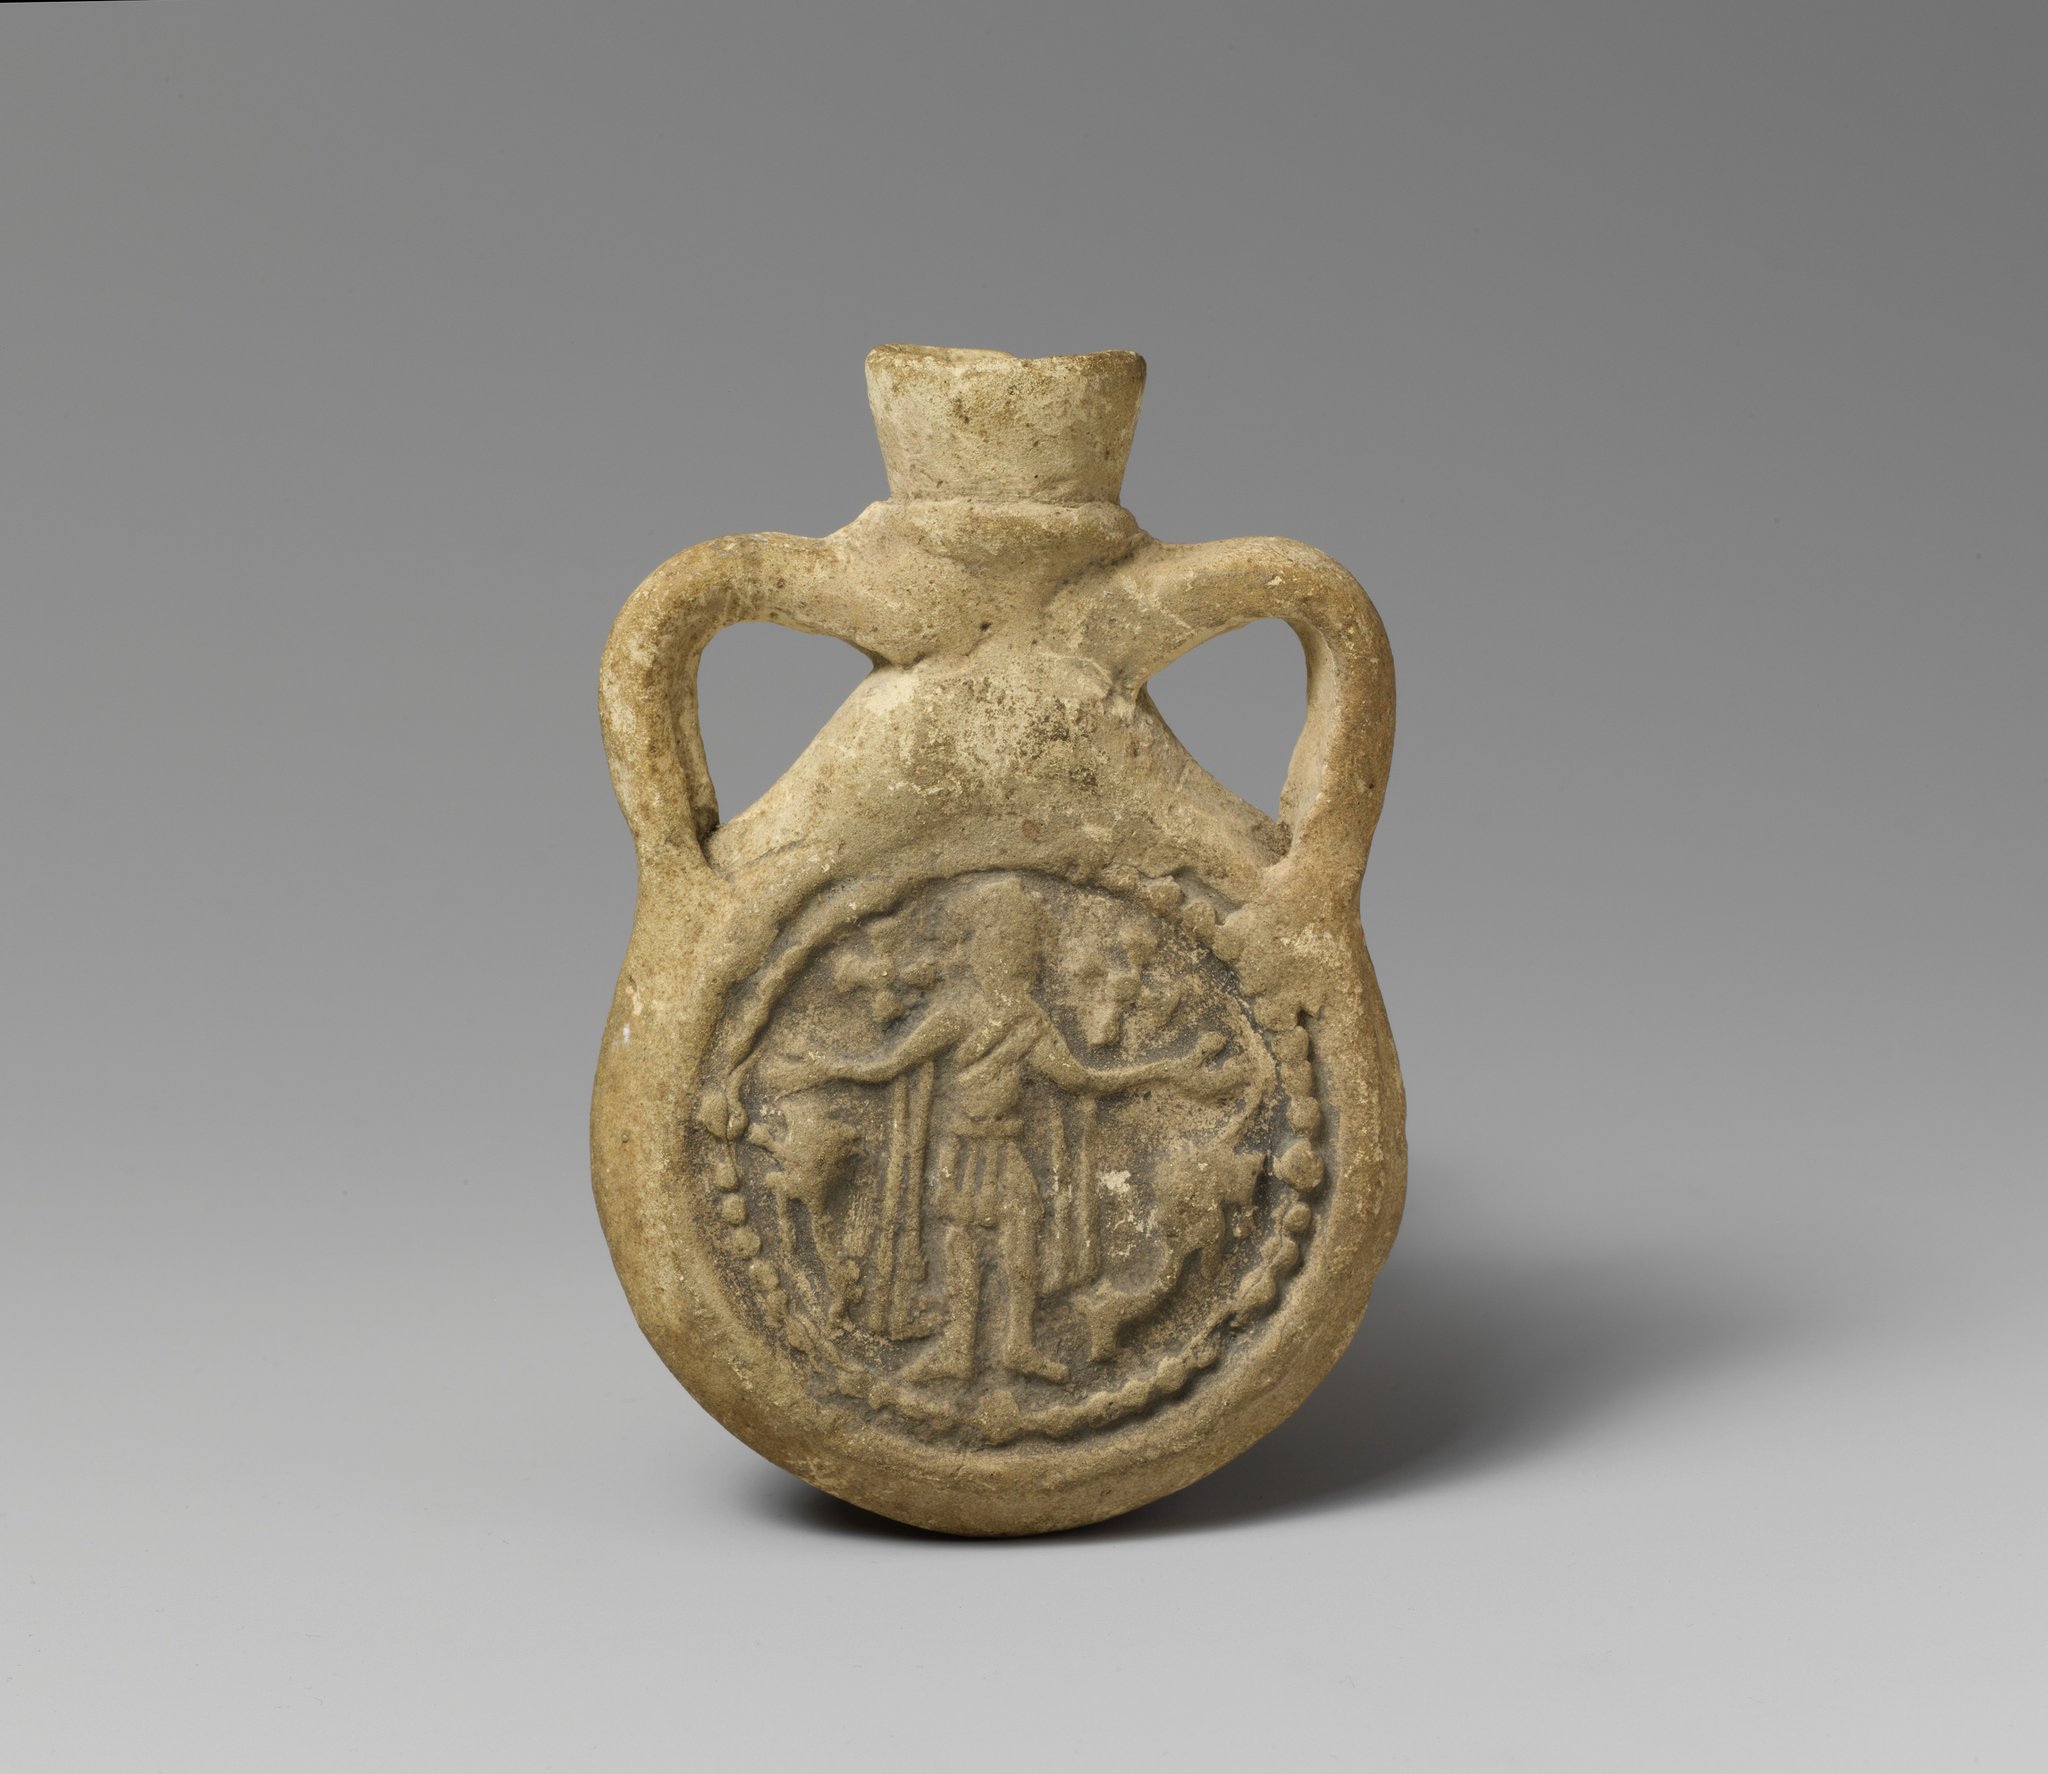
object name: pilgrim flask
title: Pilgrim Flask with Saint Menas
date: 301-700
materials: earthenware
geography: egypt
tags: saints